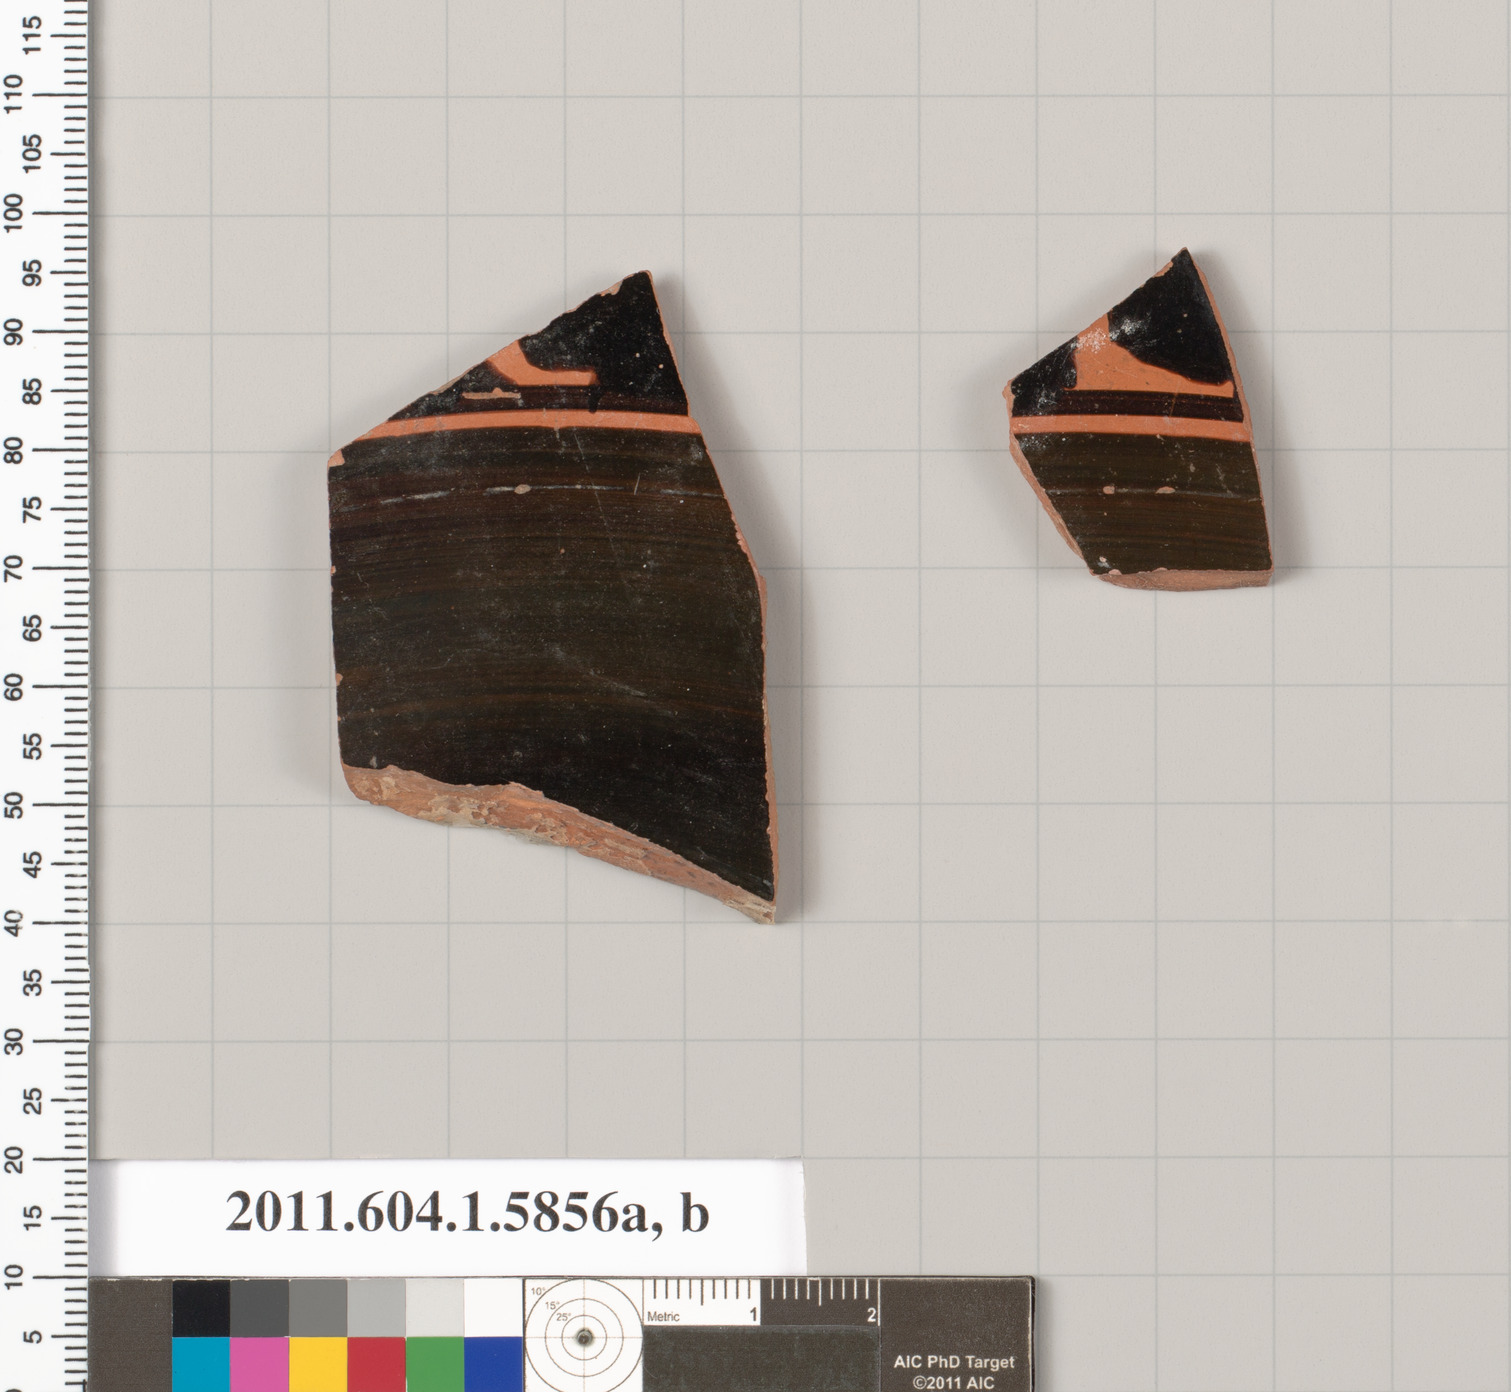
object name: kylix fragment, eye cup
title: Terracotta fragments of a kylix: eye-cup (drinking cup)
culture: greek, attic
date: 433-567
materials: terracotta